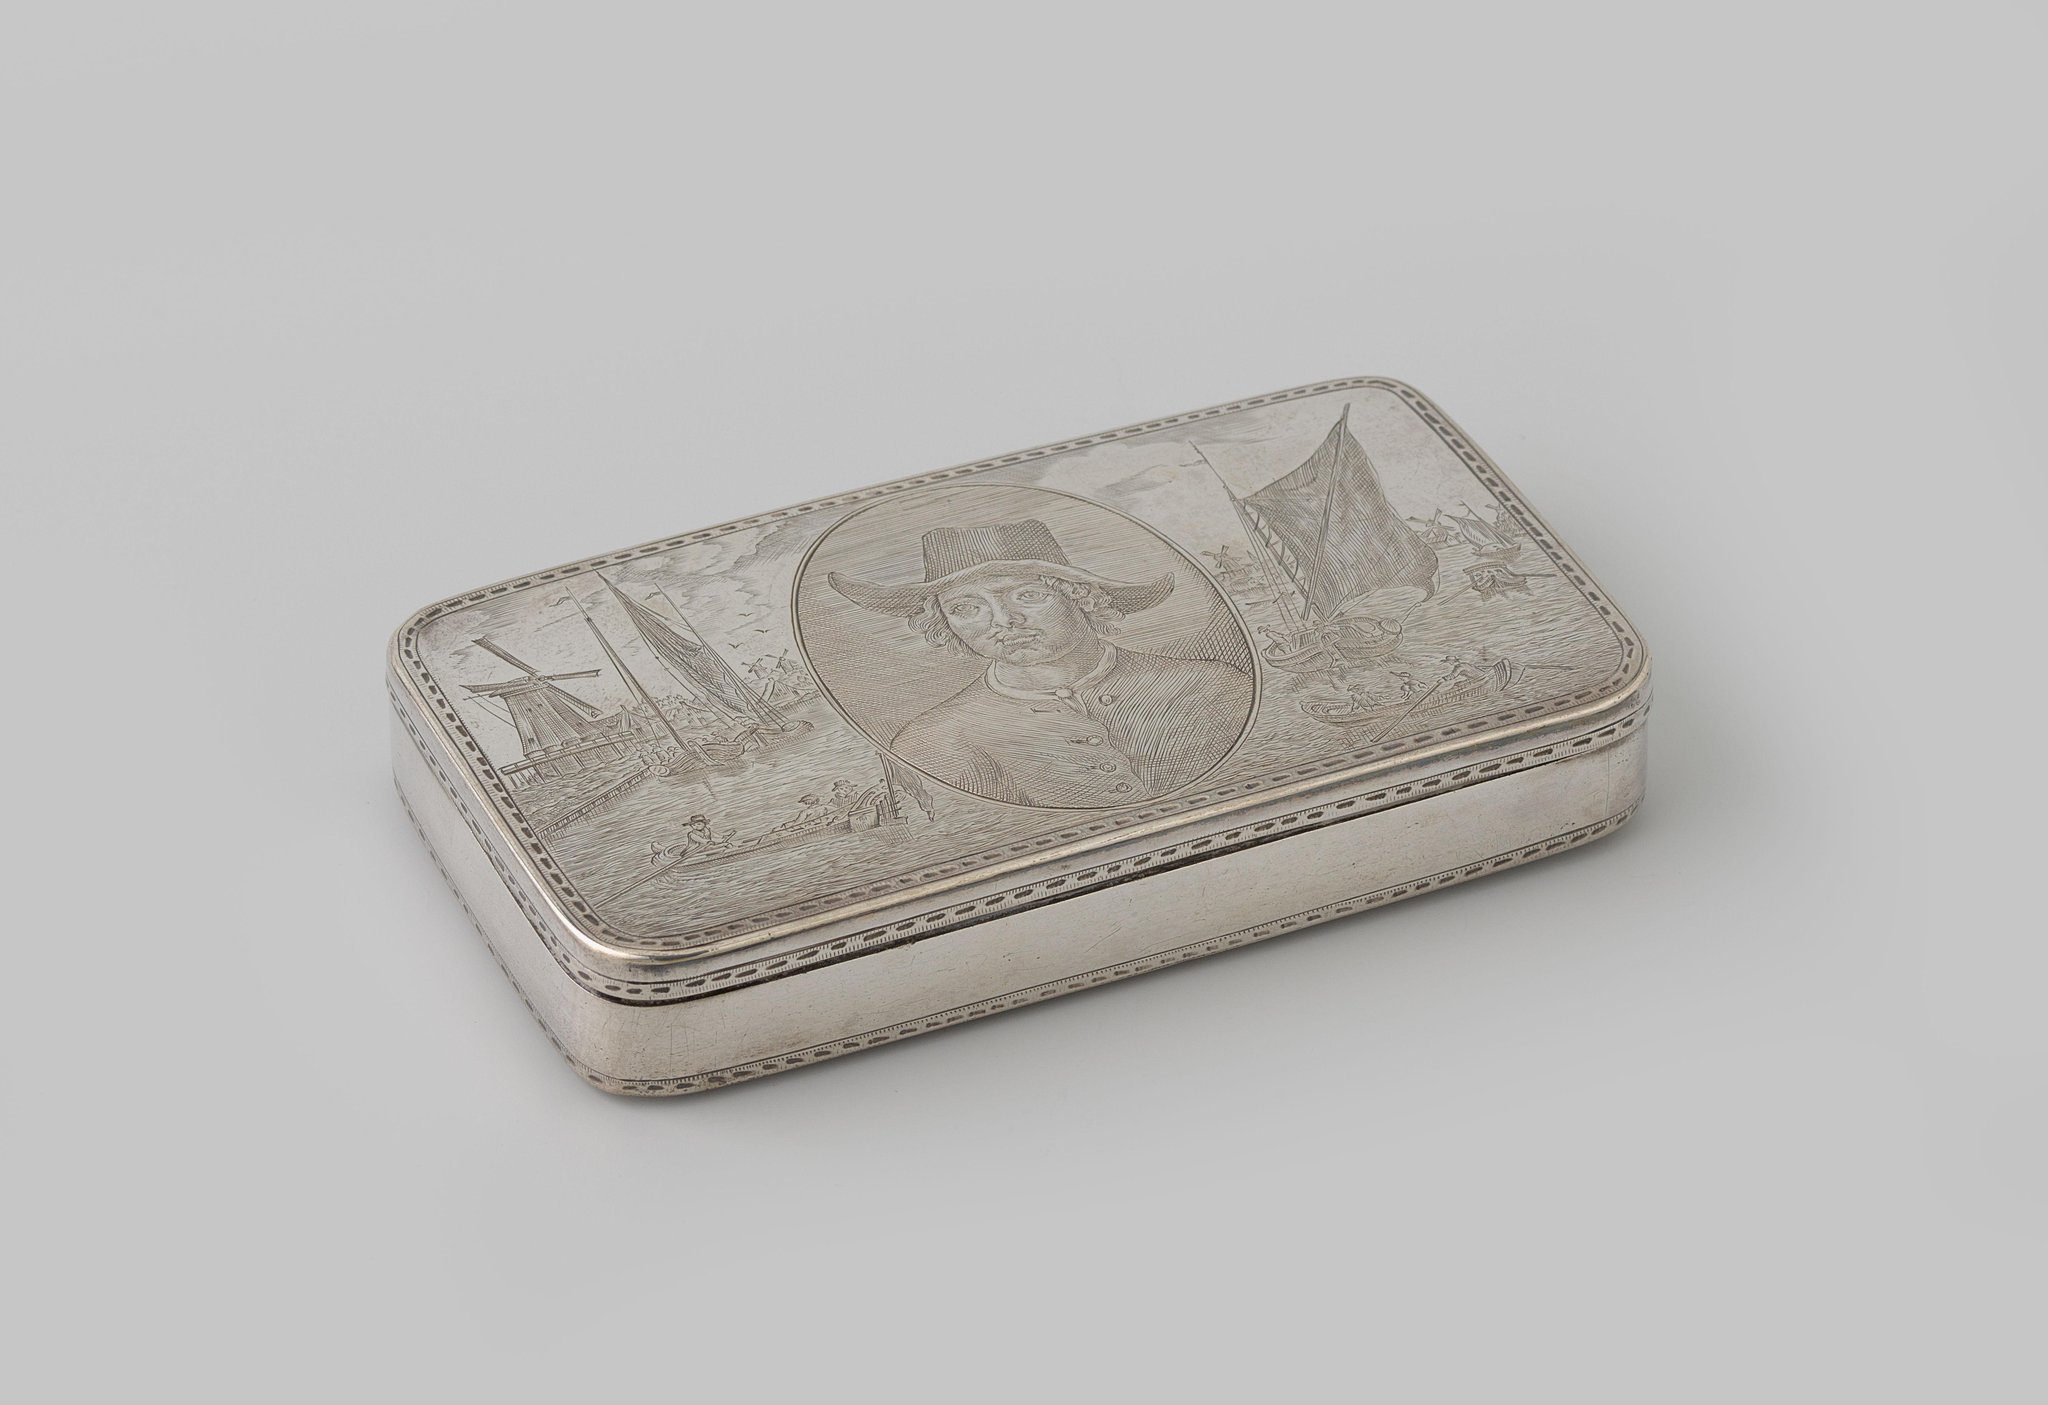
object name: tobacco box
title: Rechthoekige tabaksdoos van zilver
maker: jan van eck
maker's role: silversmith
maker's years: 1762-1825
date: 1795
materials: silver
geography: schoonhoven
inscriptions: mark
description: Rechthoekige tabaksdoos met scharnierend deksel, het deksel is versierd met het portret van Tsaar Peter I, geflankeerd door zeilende schepen, de onderzijde van de doos is versierd met de wapens van West en Oost Zaandam, gevat in rococo vormen.